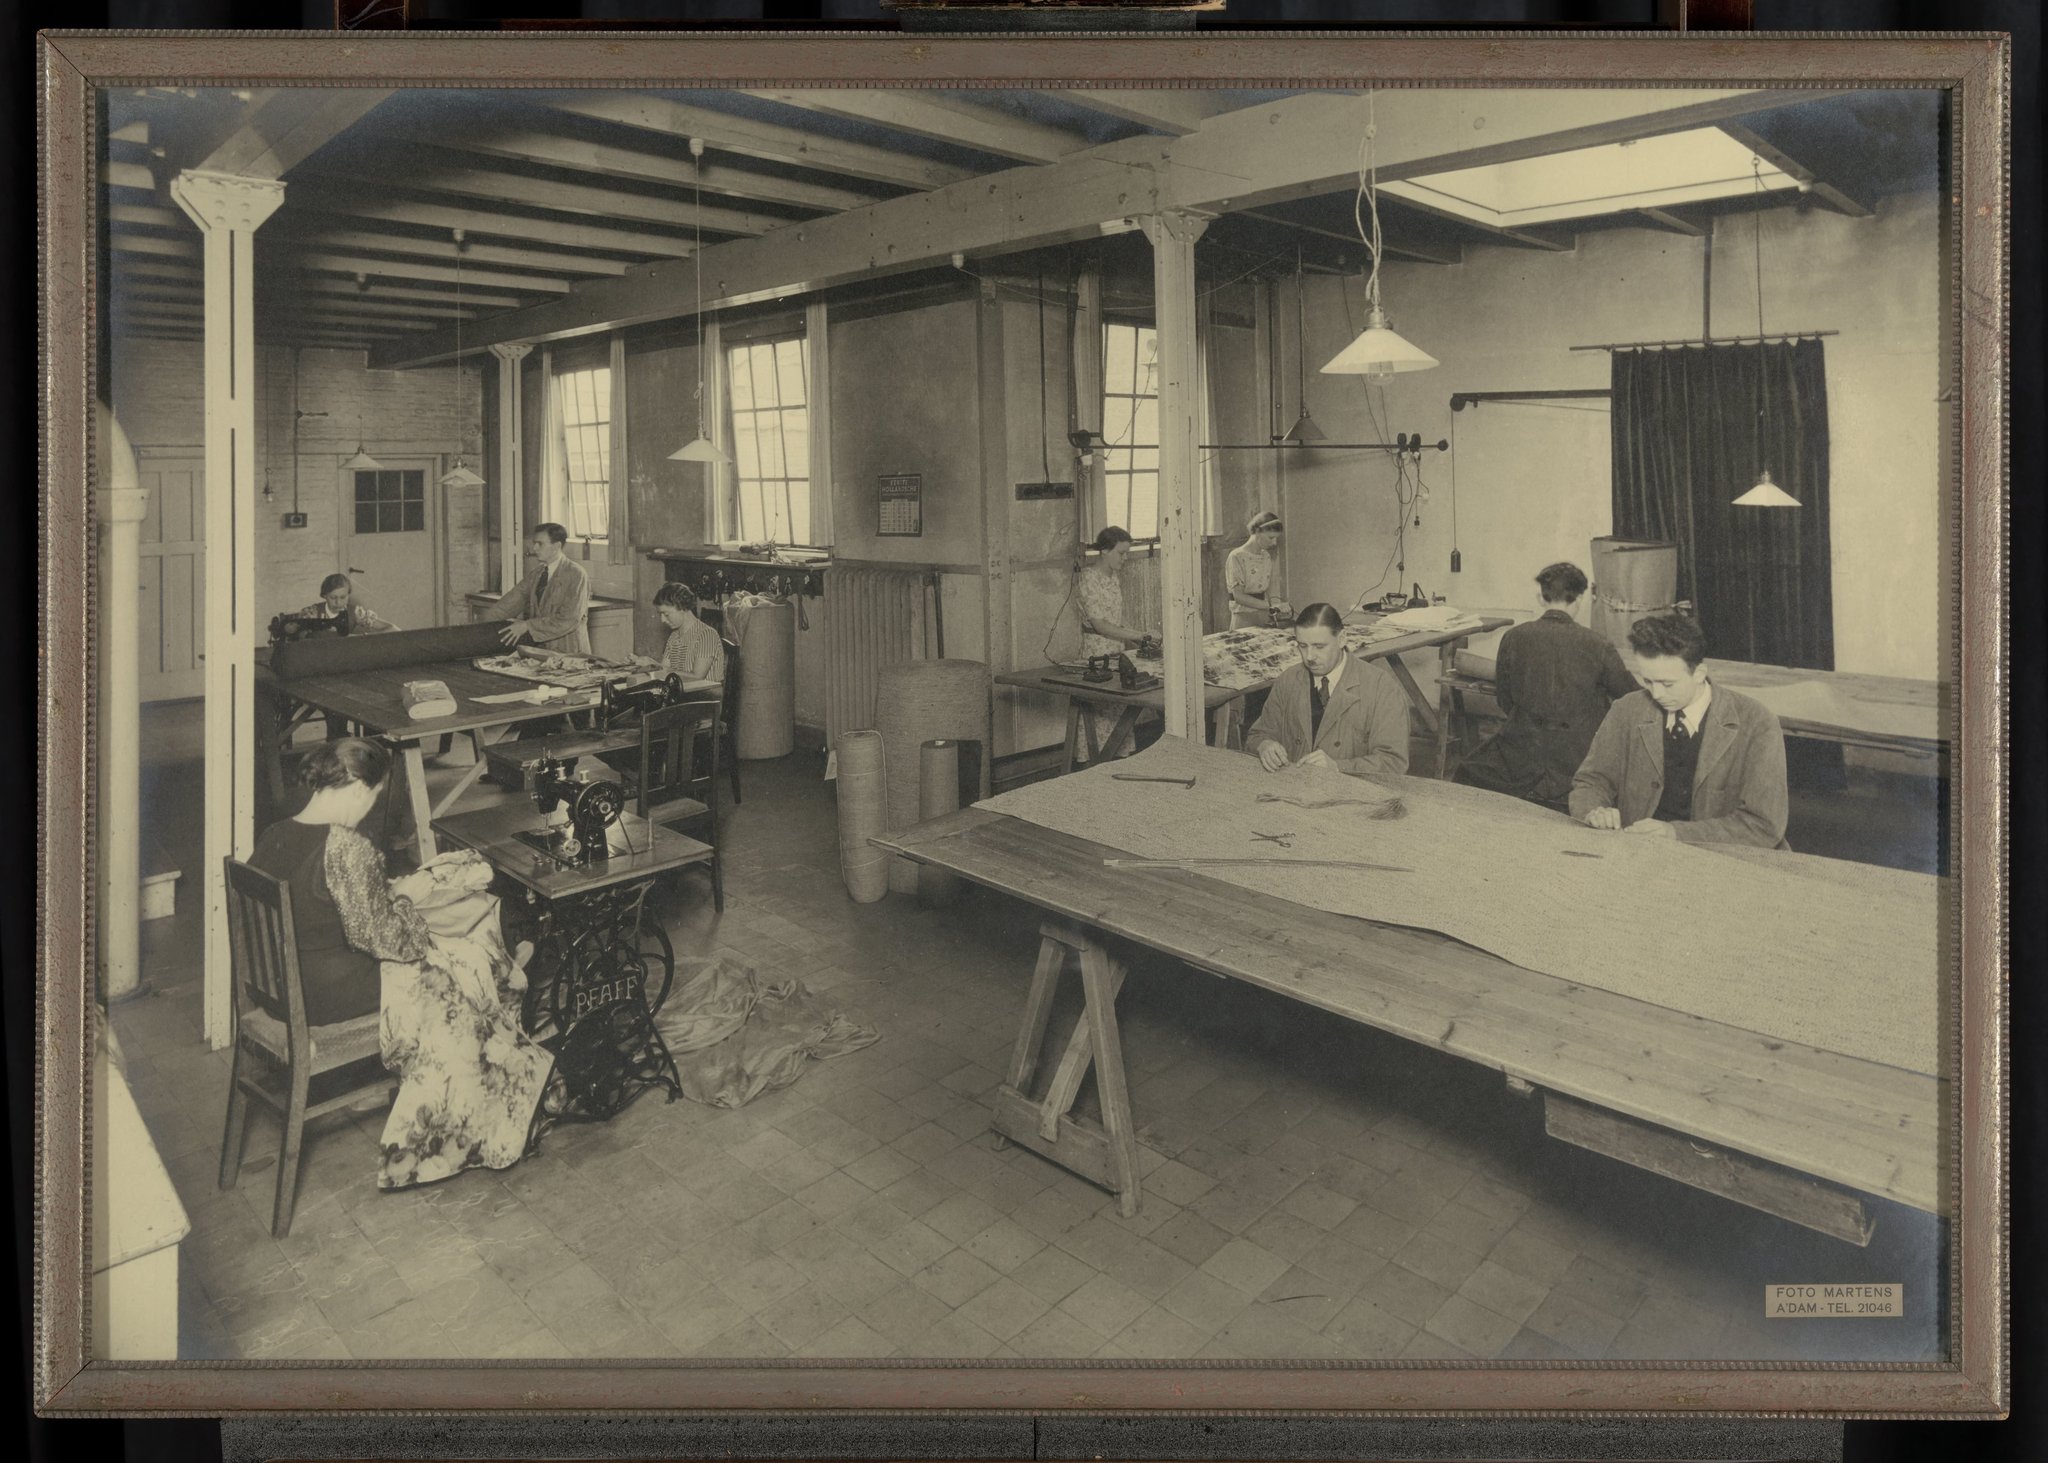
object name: photograph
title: werkplaats van 't Woonhuys, Amsterdam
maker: martens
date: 1925-1940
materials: cardboard, glass, photographic support, wood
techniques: gelatin silver print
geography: amsterdam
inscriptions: label: ‘FOTO MARTENS / A'DAM - TEL. 21046’